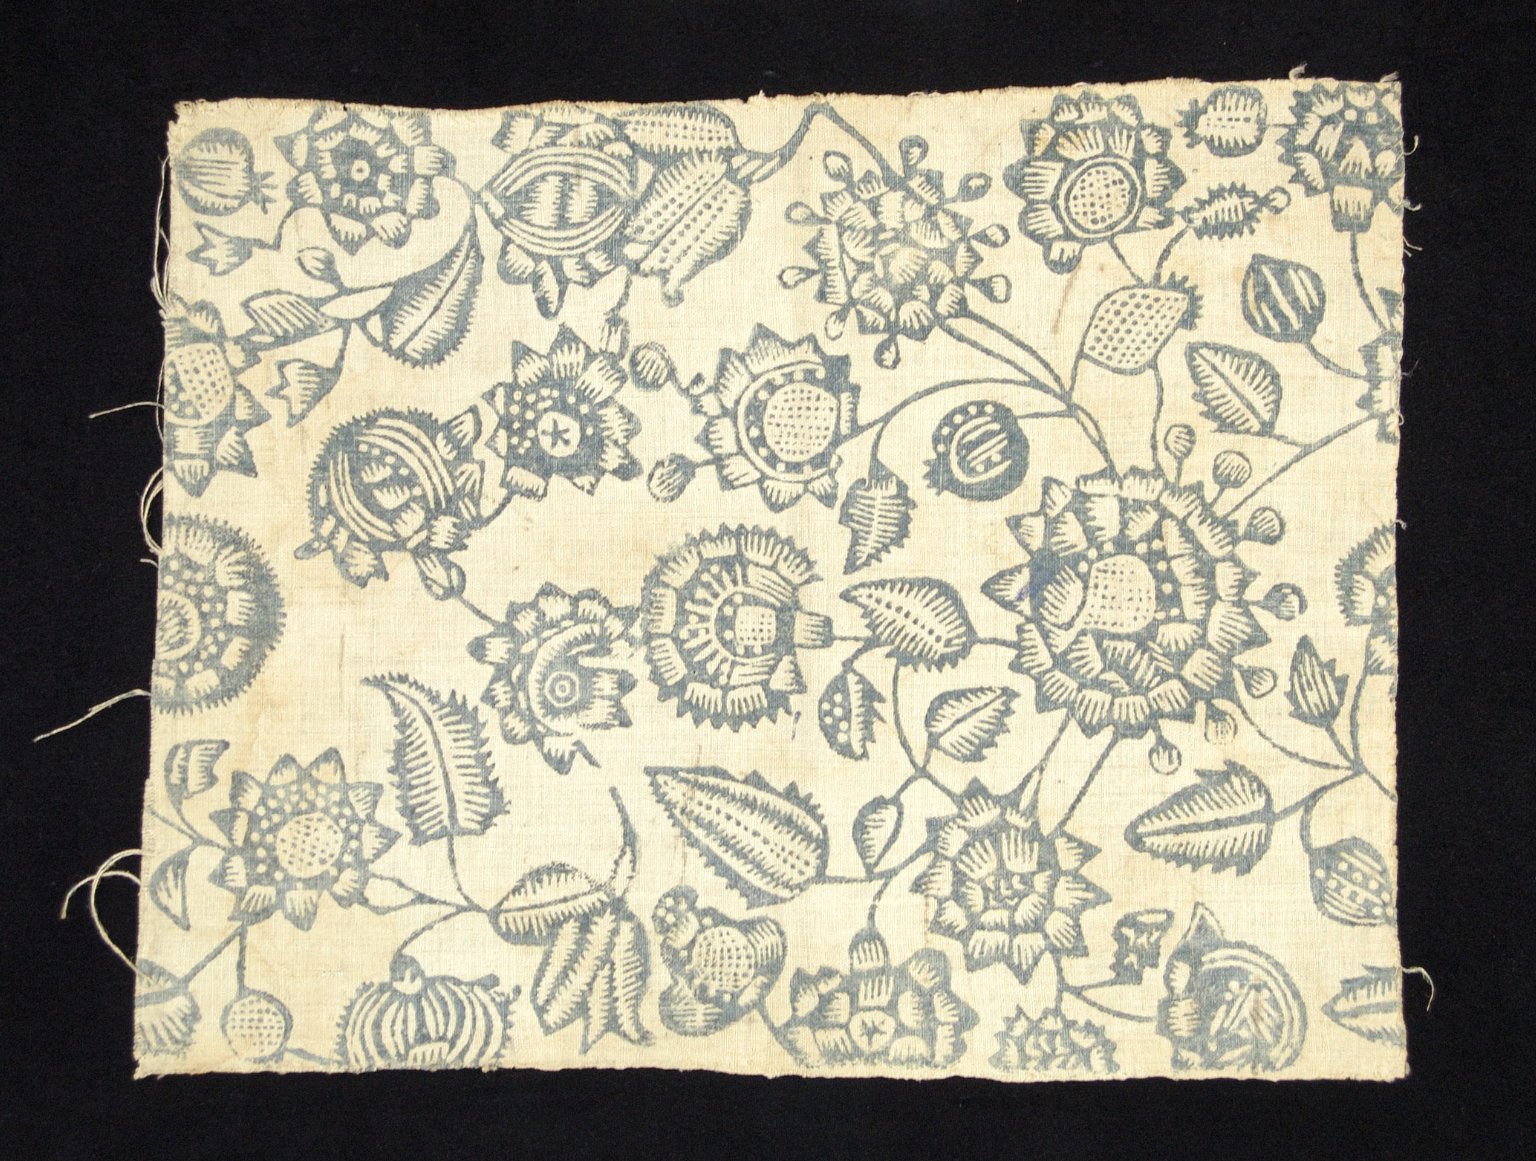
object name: textile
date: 1700-1899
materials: linen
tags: flowers